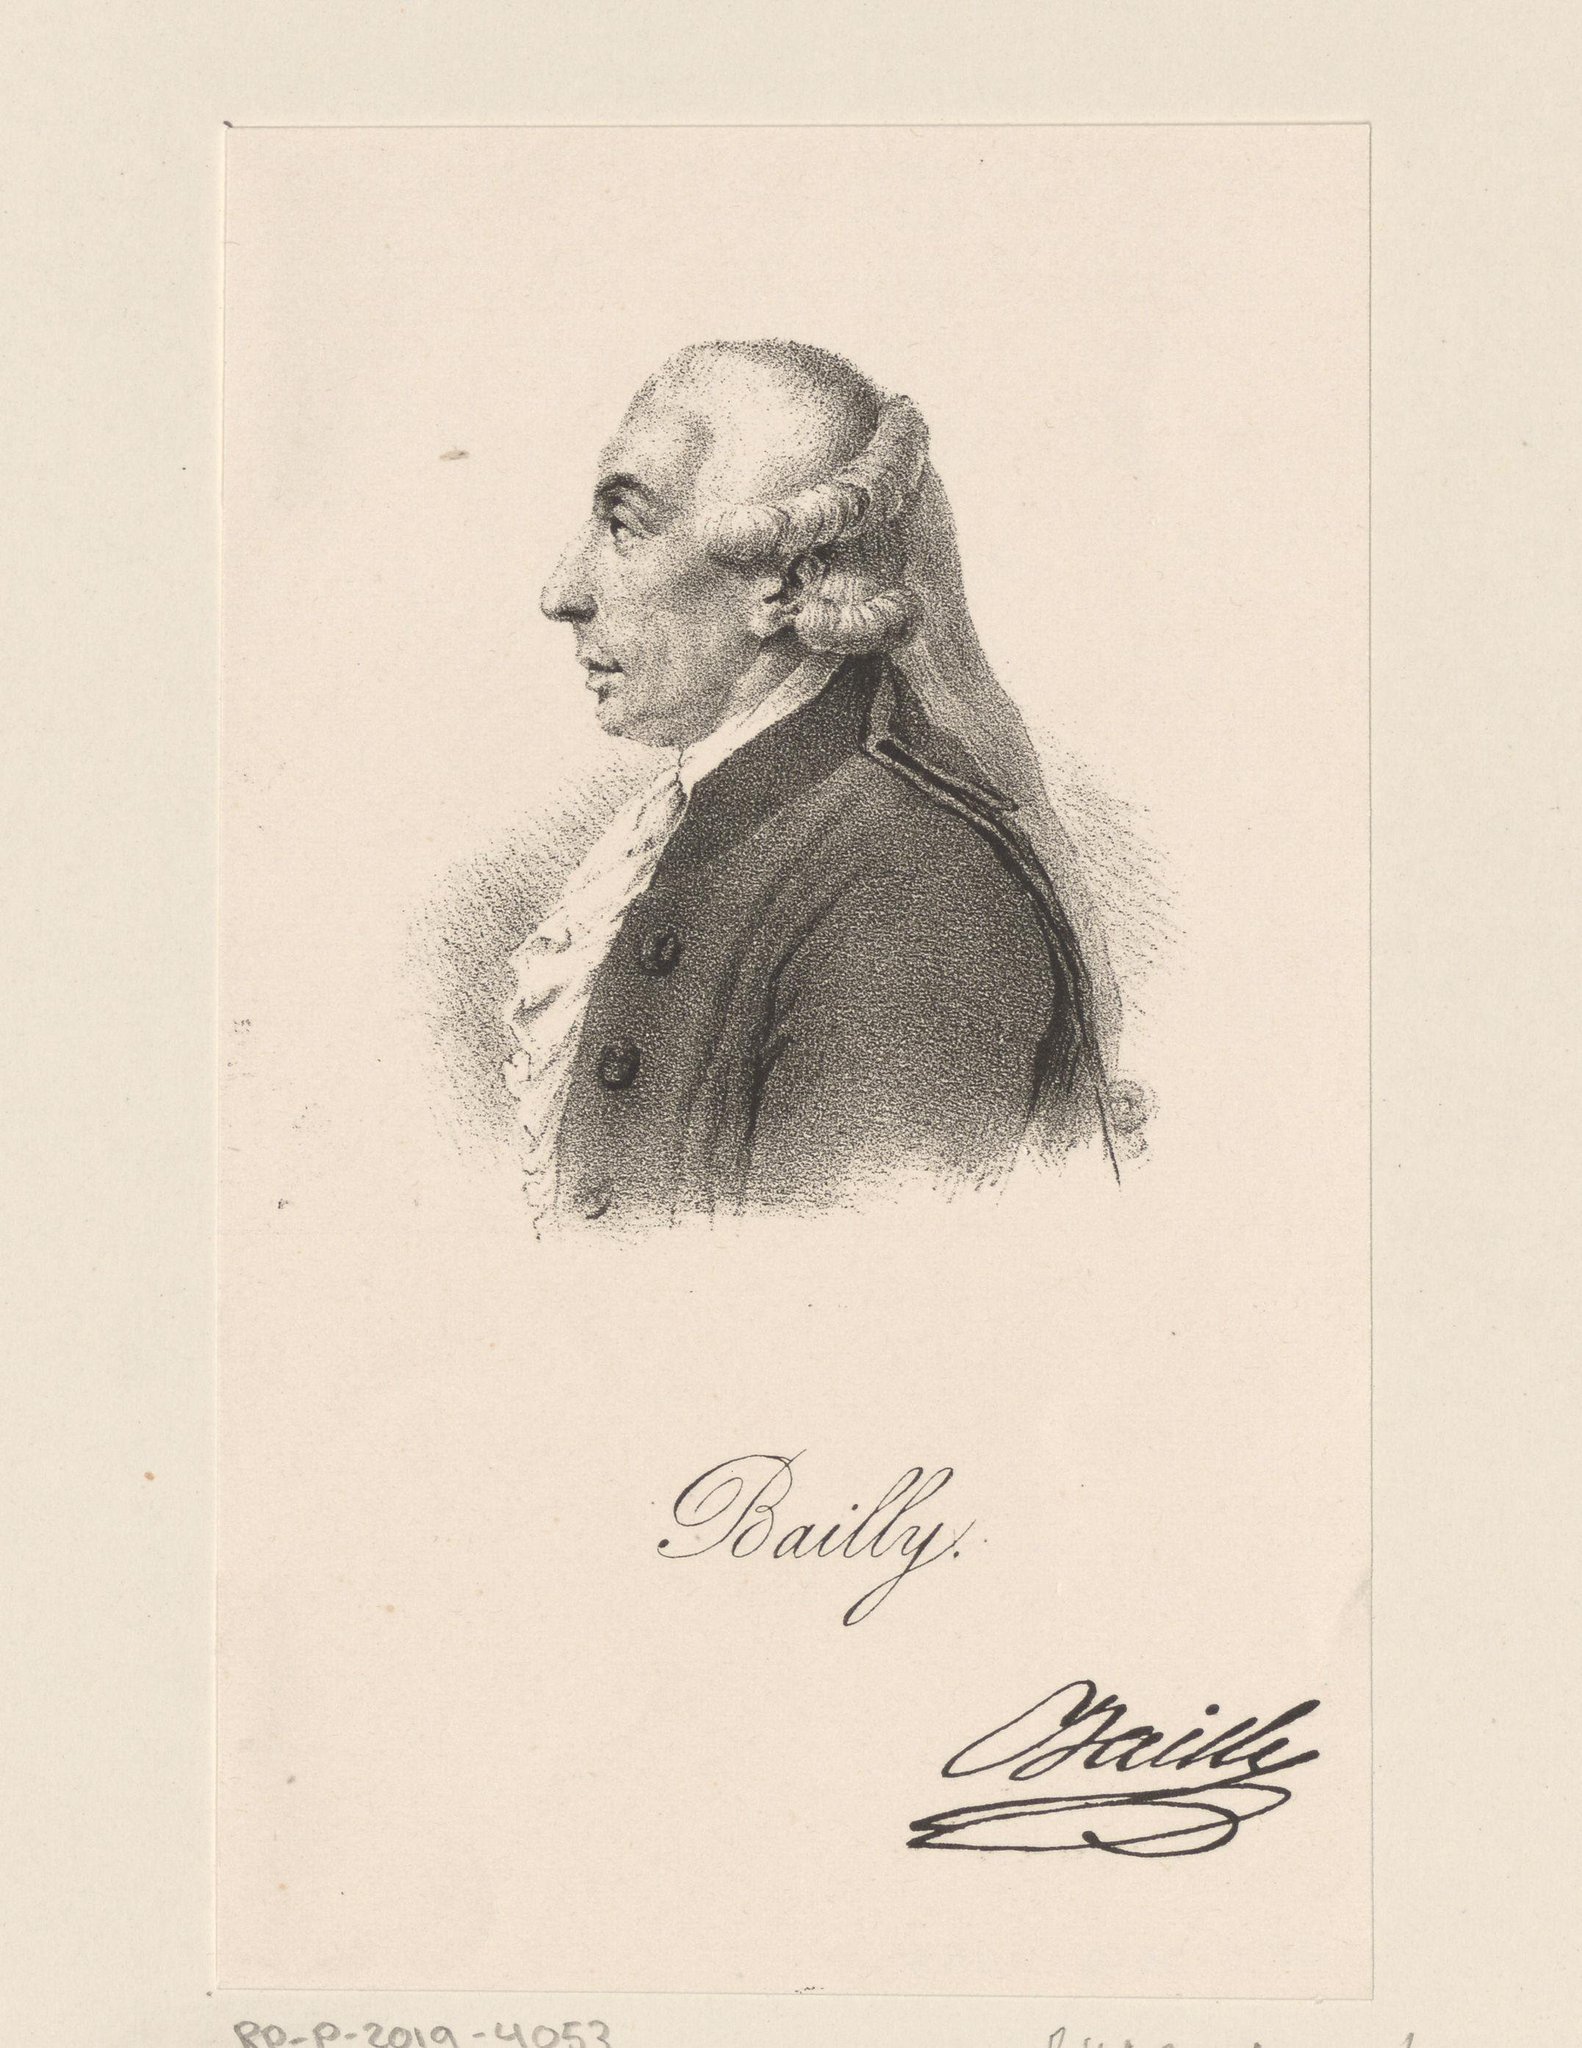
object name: print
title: Portret van Jean Sylvain Bailly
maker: Anonymous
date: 1800-1849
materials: paper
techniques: lithograph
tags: paris, politician, mayor, historical persons